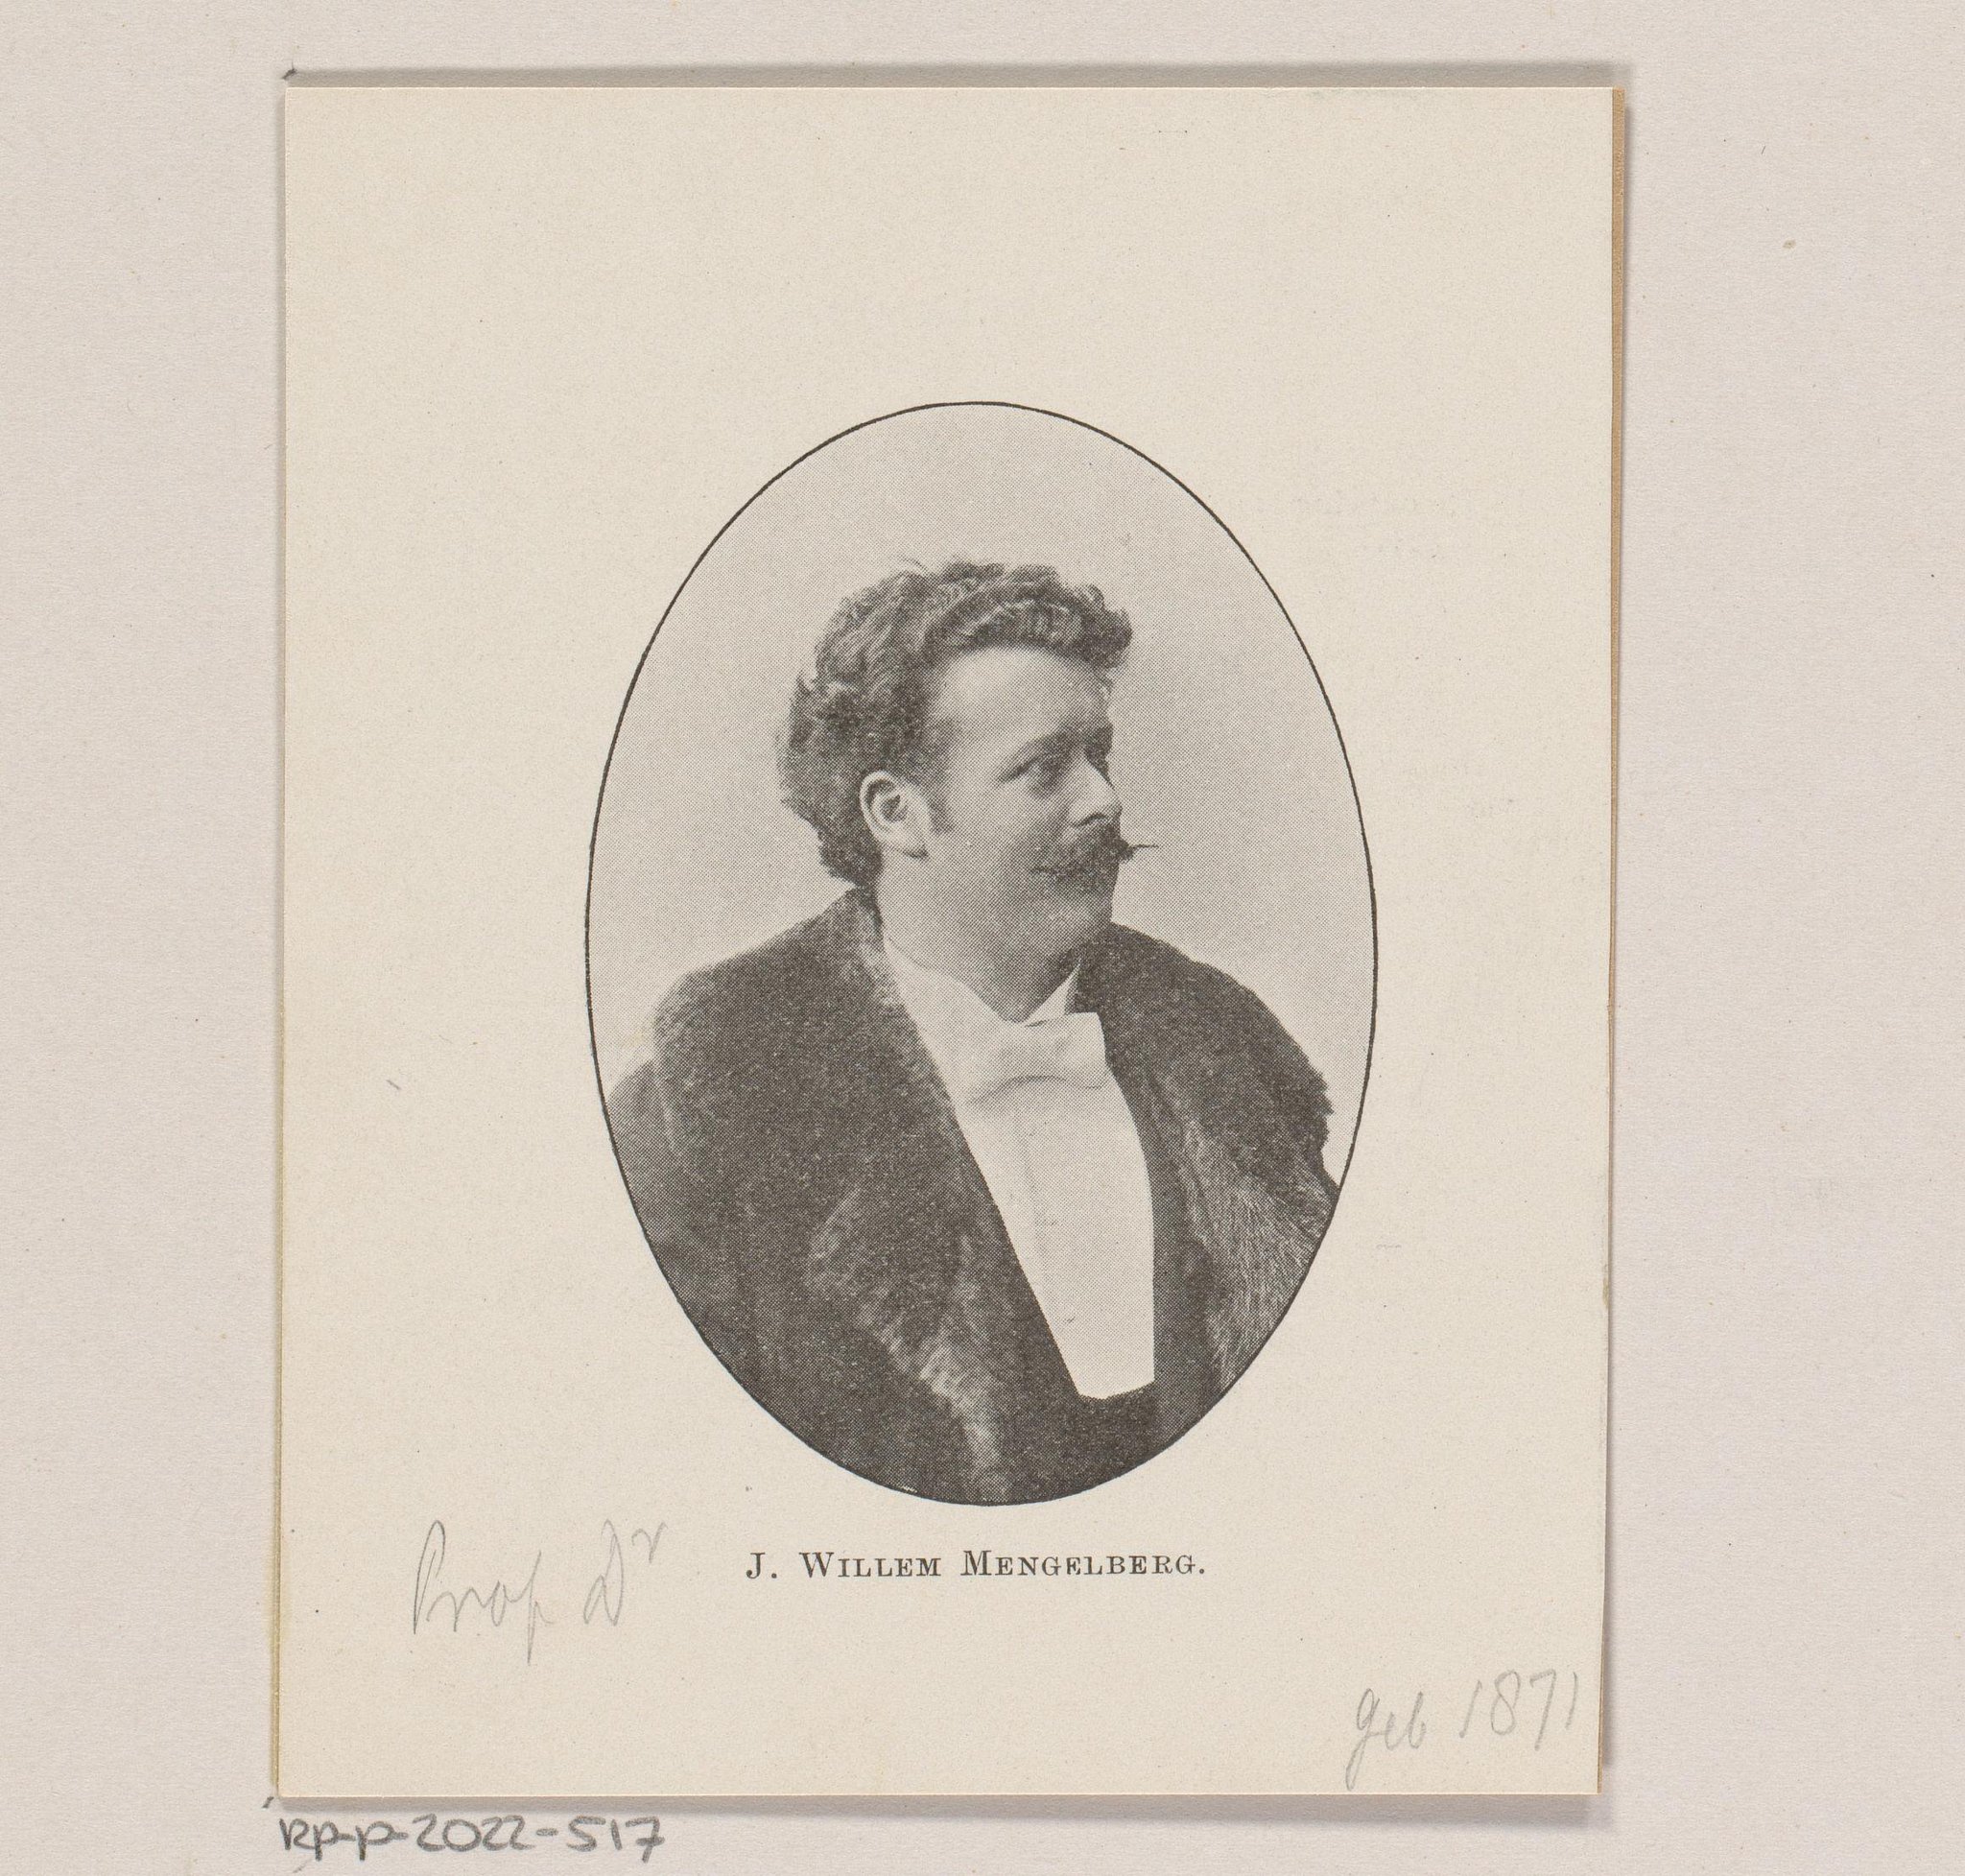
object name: photomechanical print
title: Portret van Willem Mengelberg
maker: Anonymous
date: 1895-1970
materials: paper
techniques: autotype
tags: utrecht, historical persons, conductor ~ music